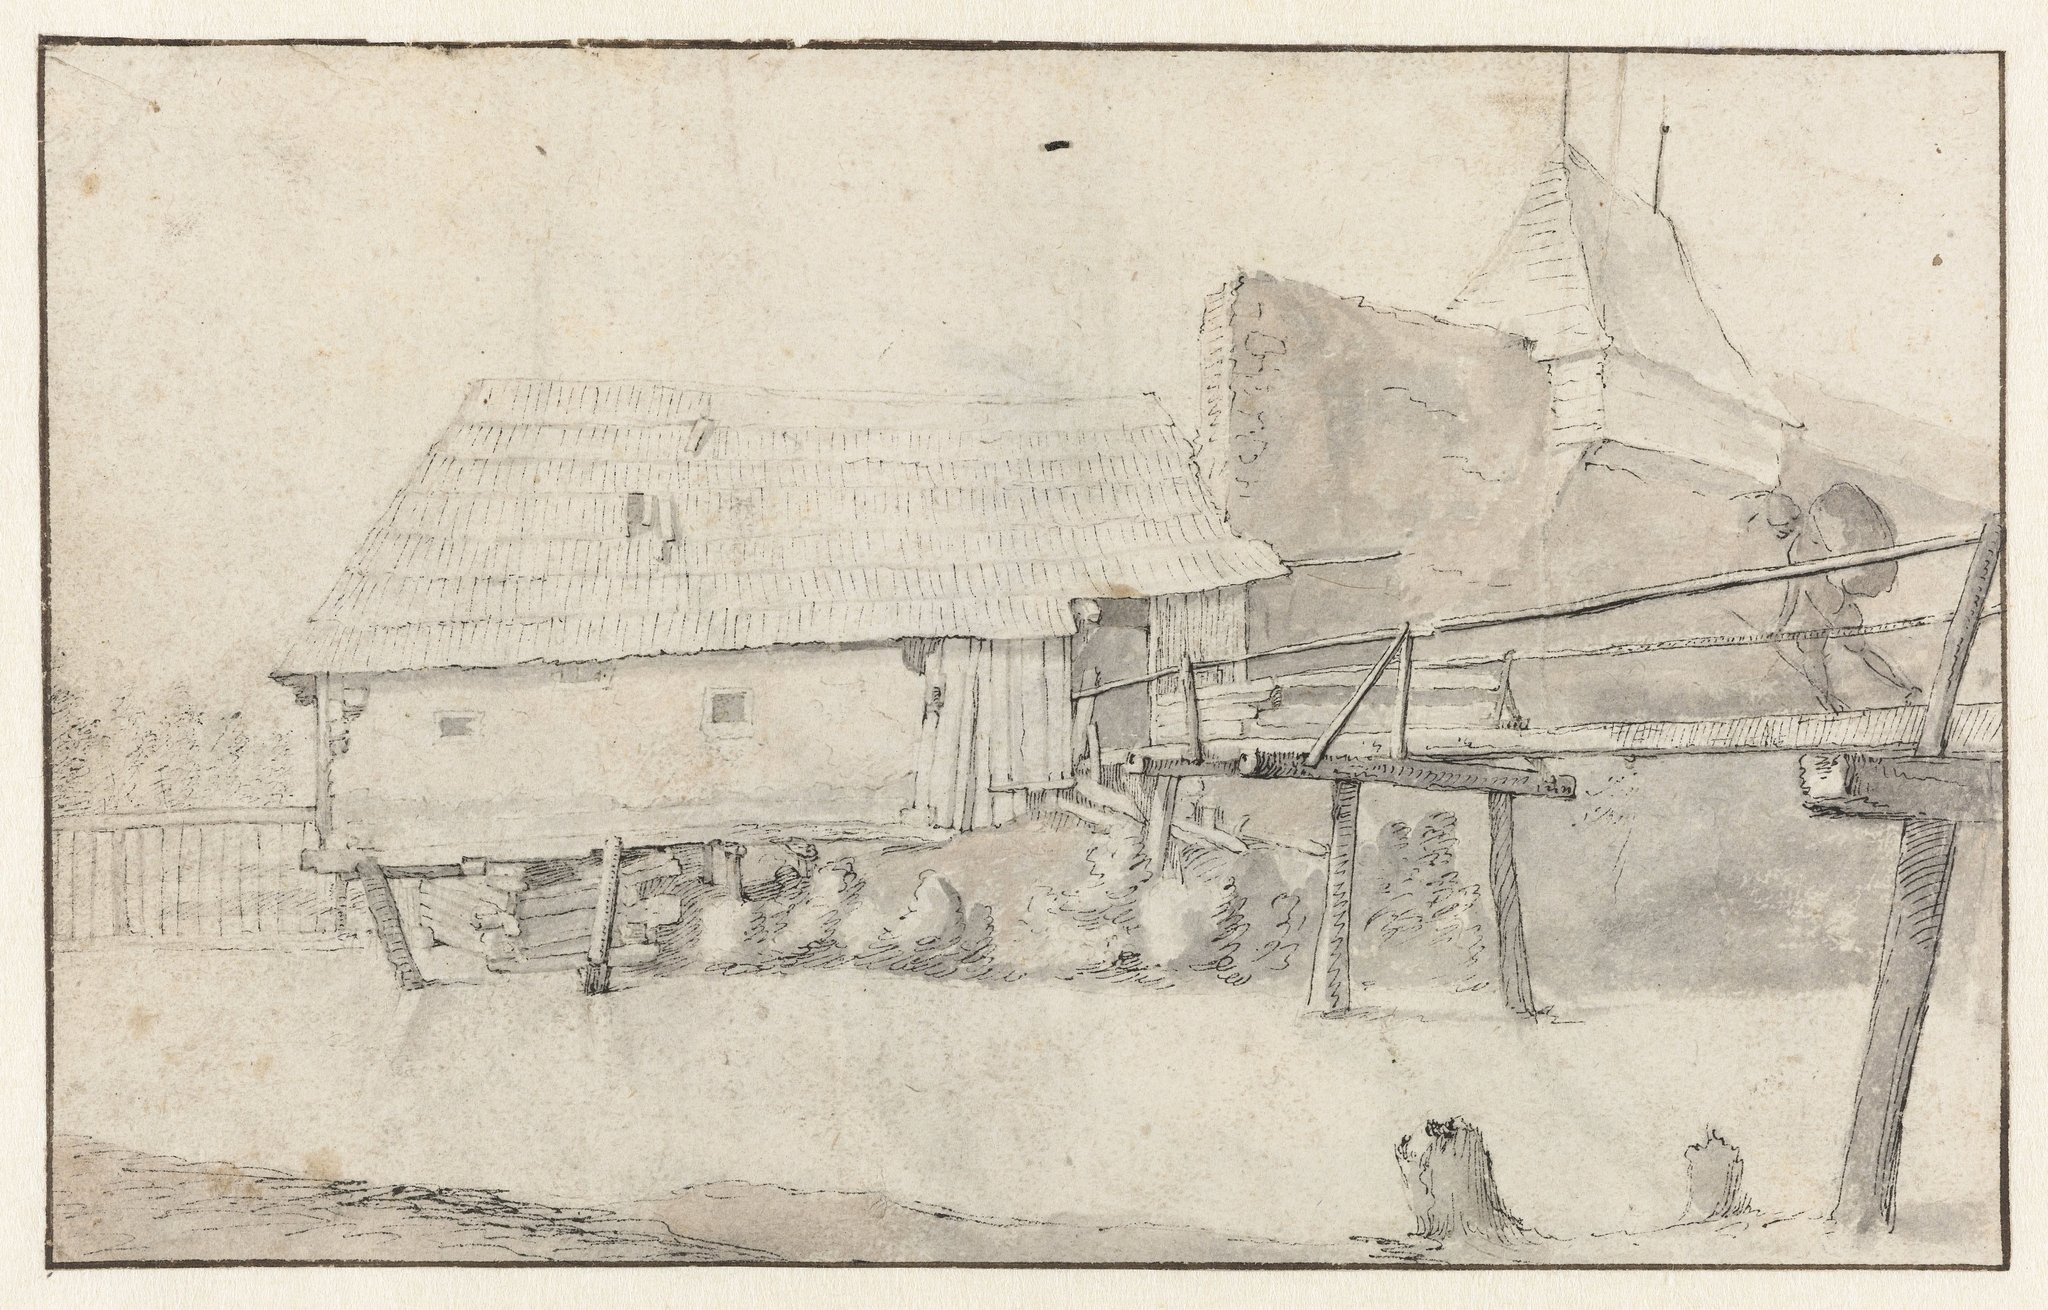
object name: drawing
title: A Wooden Bridge Leading to a House Built above a River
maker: paulus willemsz. van vianen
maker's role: draughtsman, jeweler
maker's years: 1570-1614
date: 1603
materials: ink, paper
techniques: brush, pen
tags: landscape with bridge, viaduct or aqueduct, bridge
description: Paulus van Vianen possessed the remarkable ability to translate his own delicately rendered landscape drawings into extraordinarily detailed chasing in silver. For example, this cottage and rickety bridge – possibly somewhere near Salzburg – appears on a silver plaquette of 1607 in the Rijksmuseum. That relief is on view in Gallery 2.3.